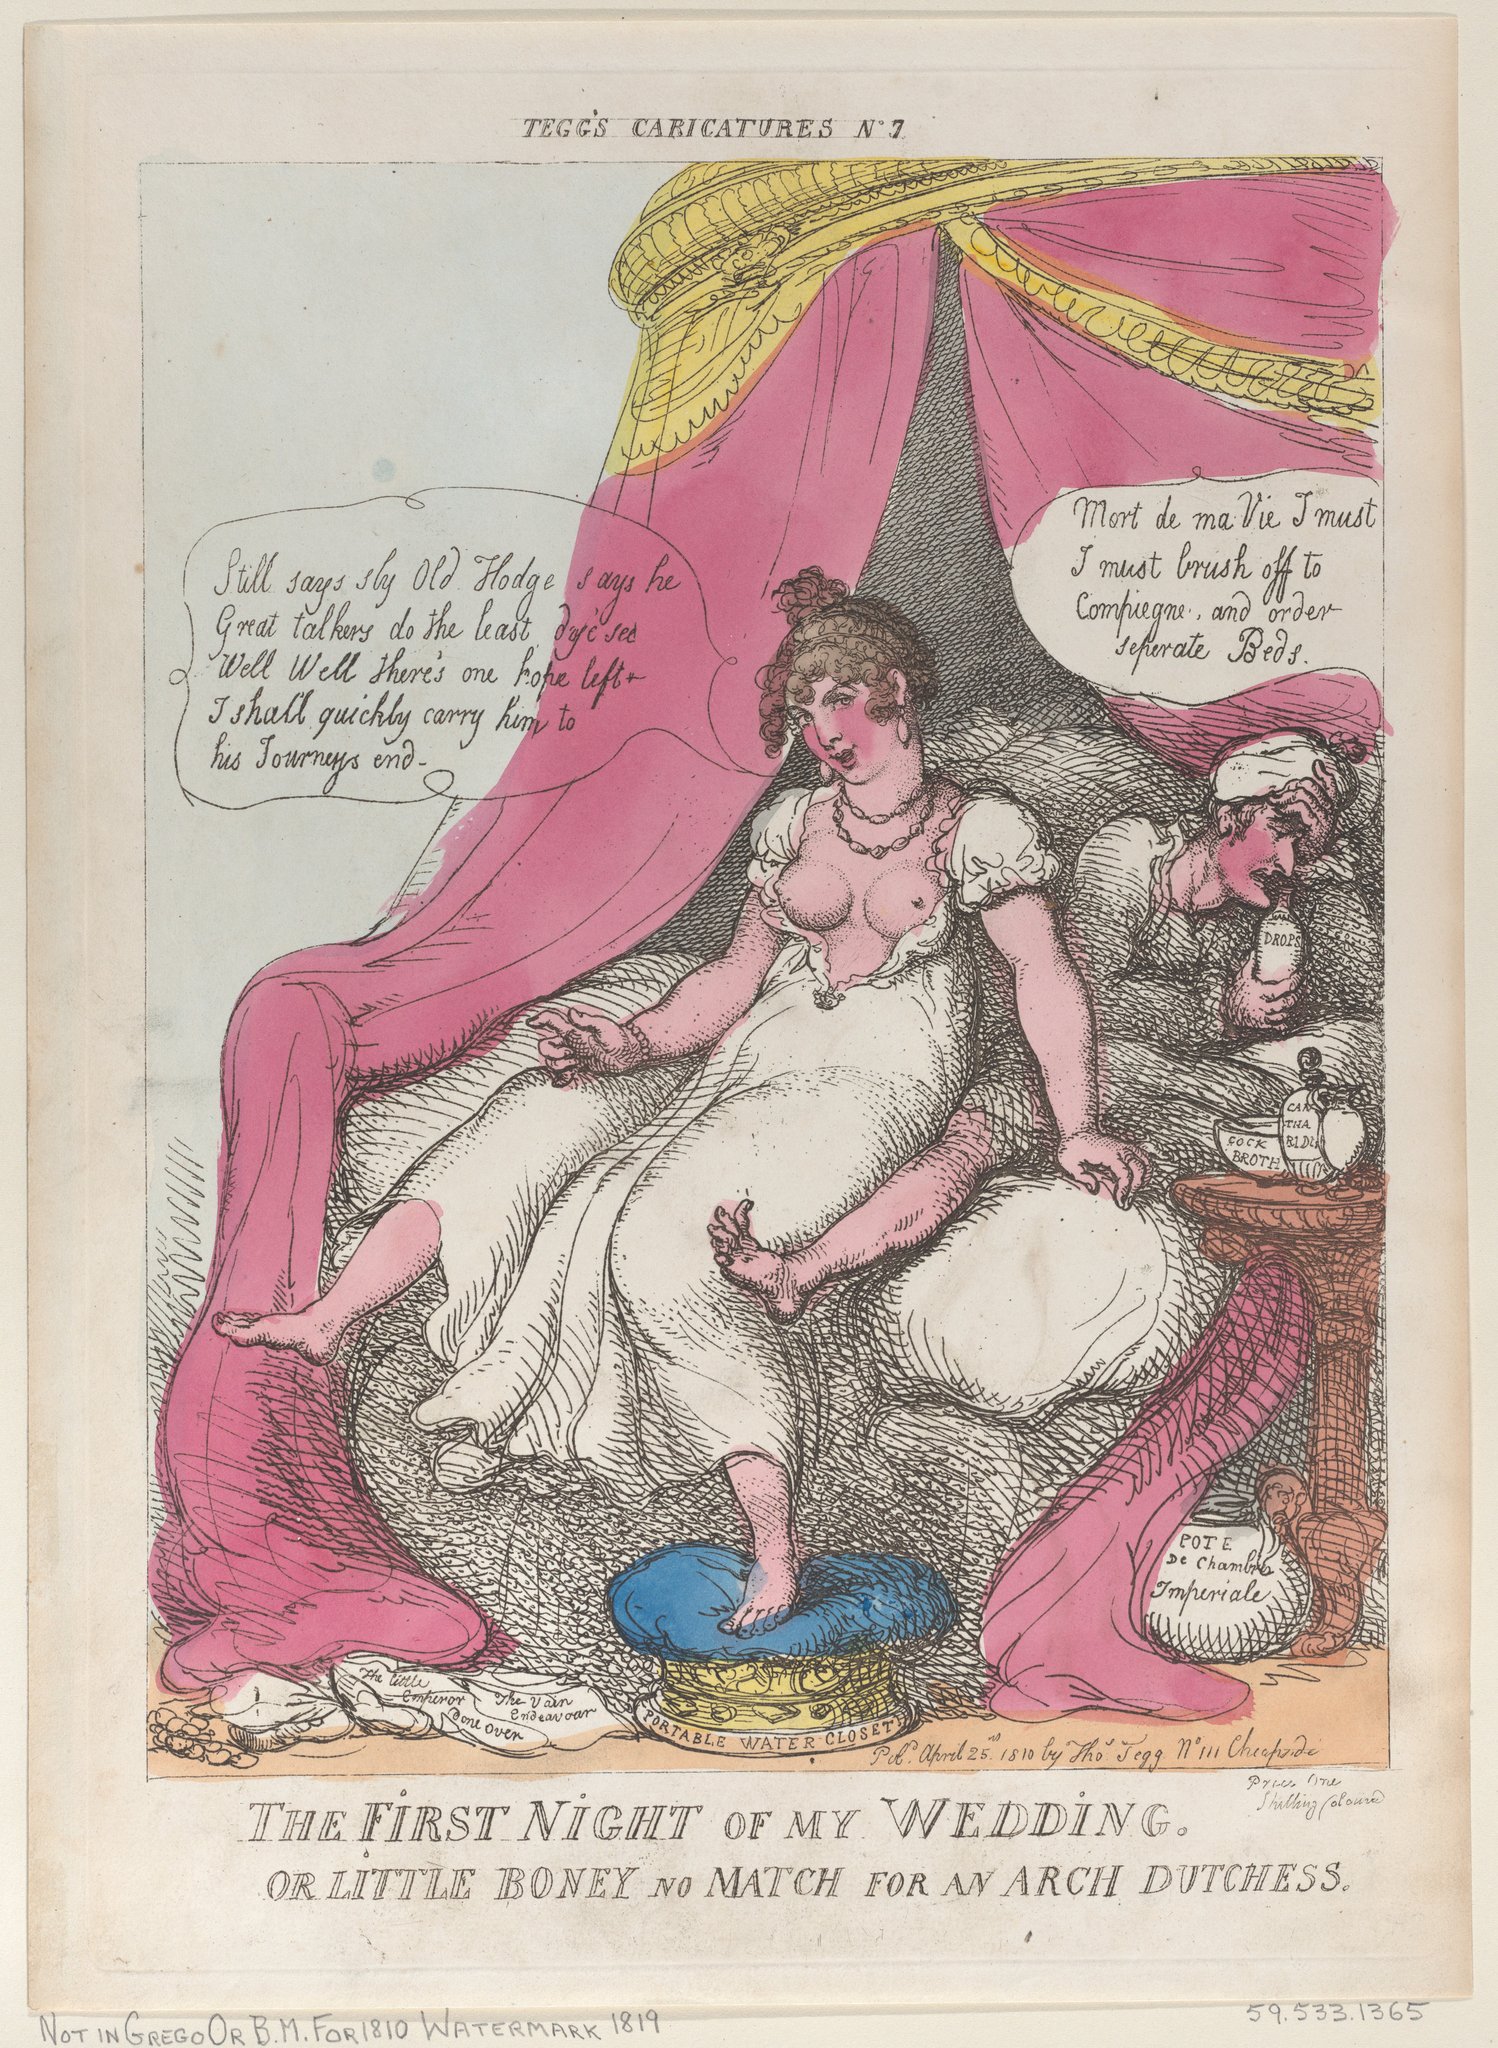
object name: print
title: The First Night of My Wedding, or Little Boney No Match For an Arch Dutchess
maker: thomas rowlandson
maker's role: artist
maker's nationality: british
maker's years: 1757-1827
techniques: etching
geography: london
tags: satire,napoleon i,men,women,beds